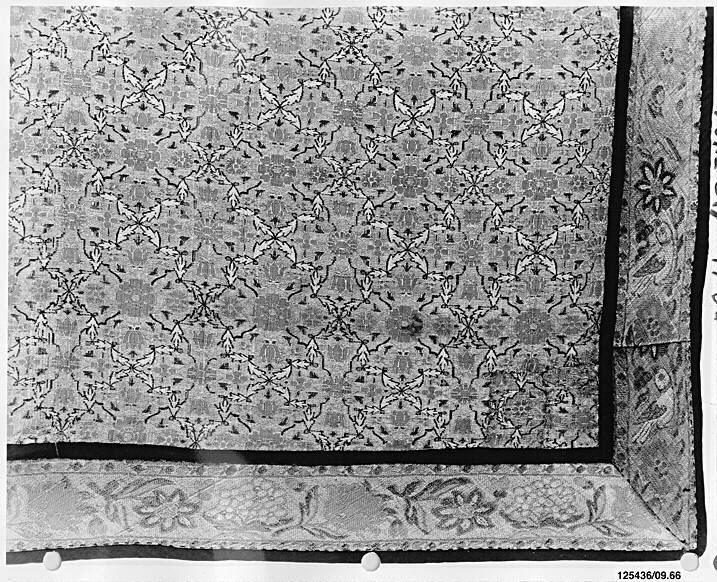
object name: cover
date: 1701-1800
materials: metal thread, silk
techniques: brocade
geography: iran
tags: flowers